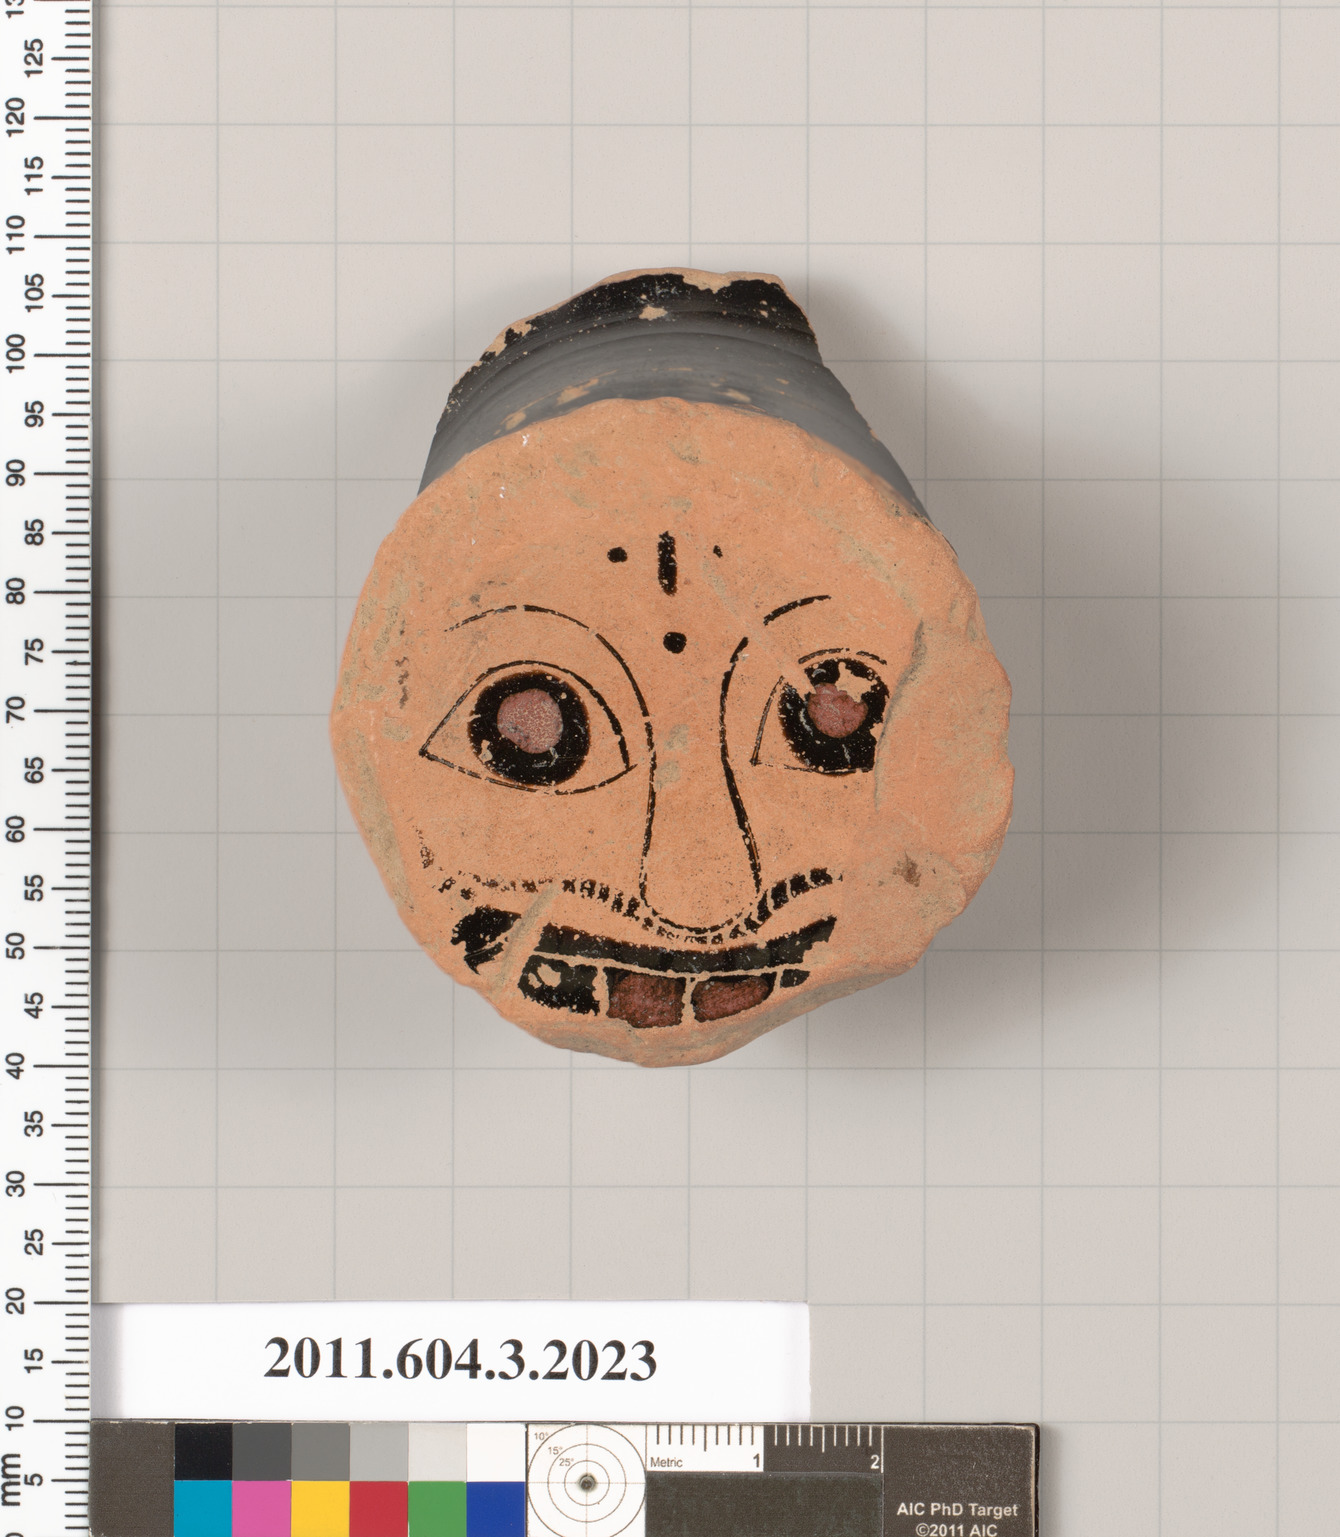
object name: kylix fragment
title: Terracotta fragment of a kylix (drinking cup)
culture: greek, attic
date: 550-526 BCE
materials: terracotta